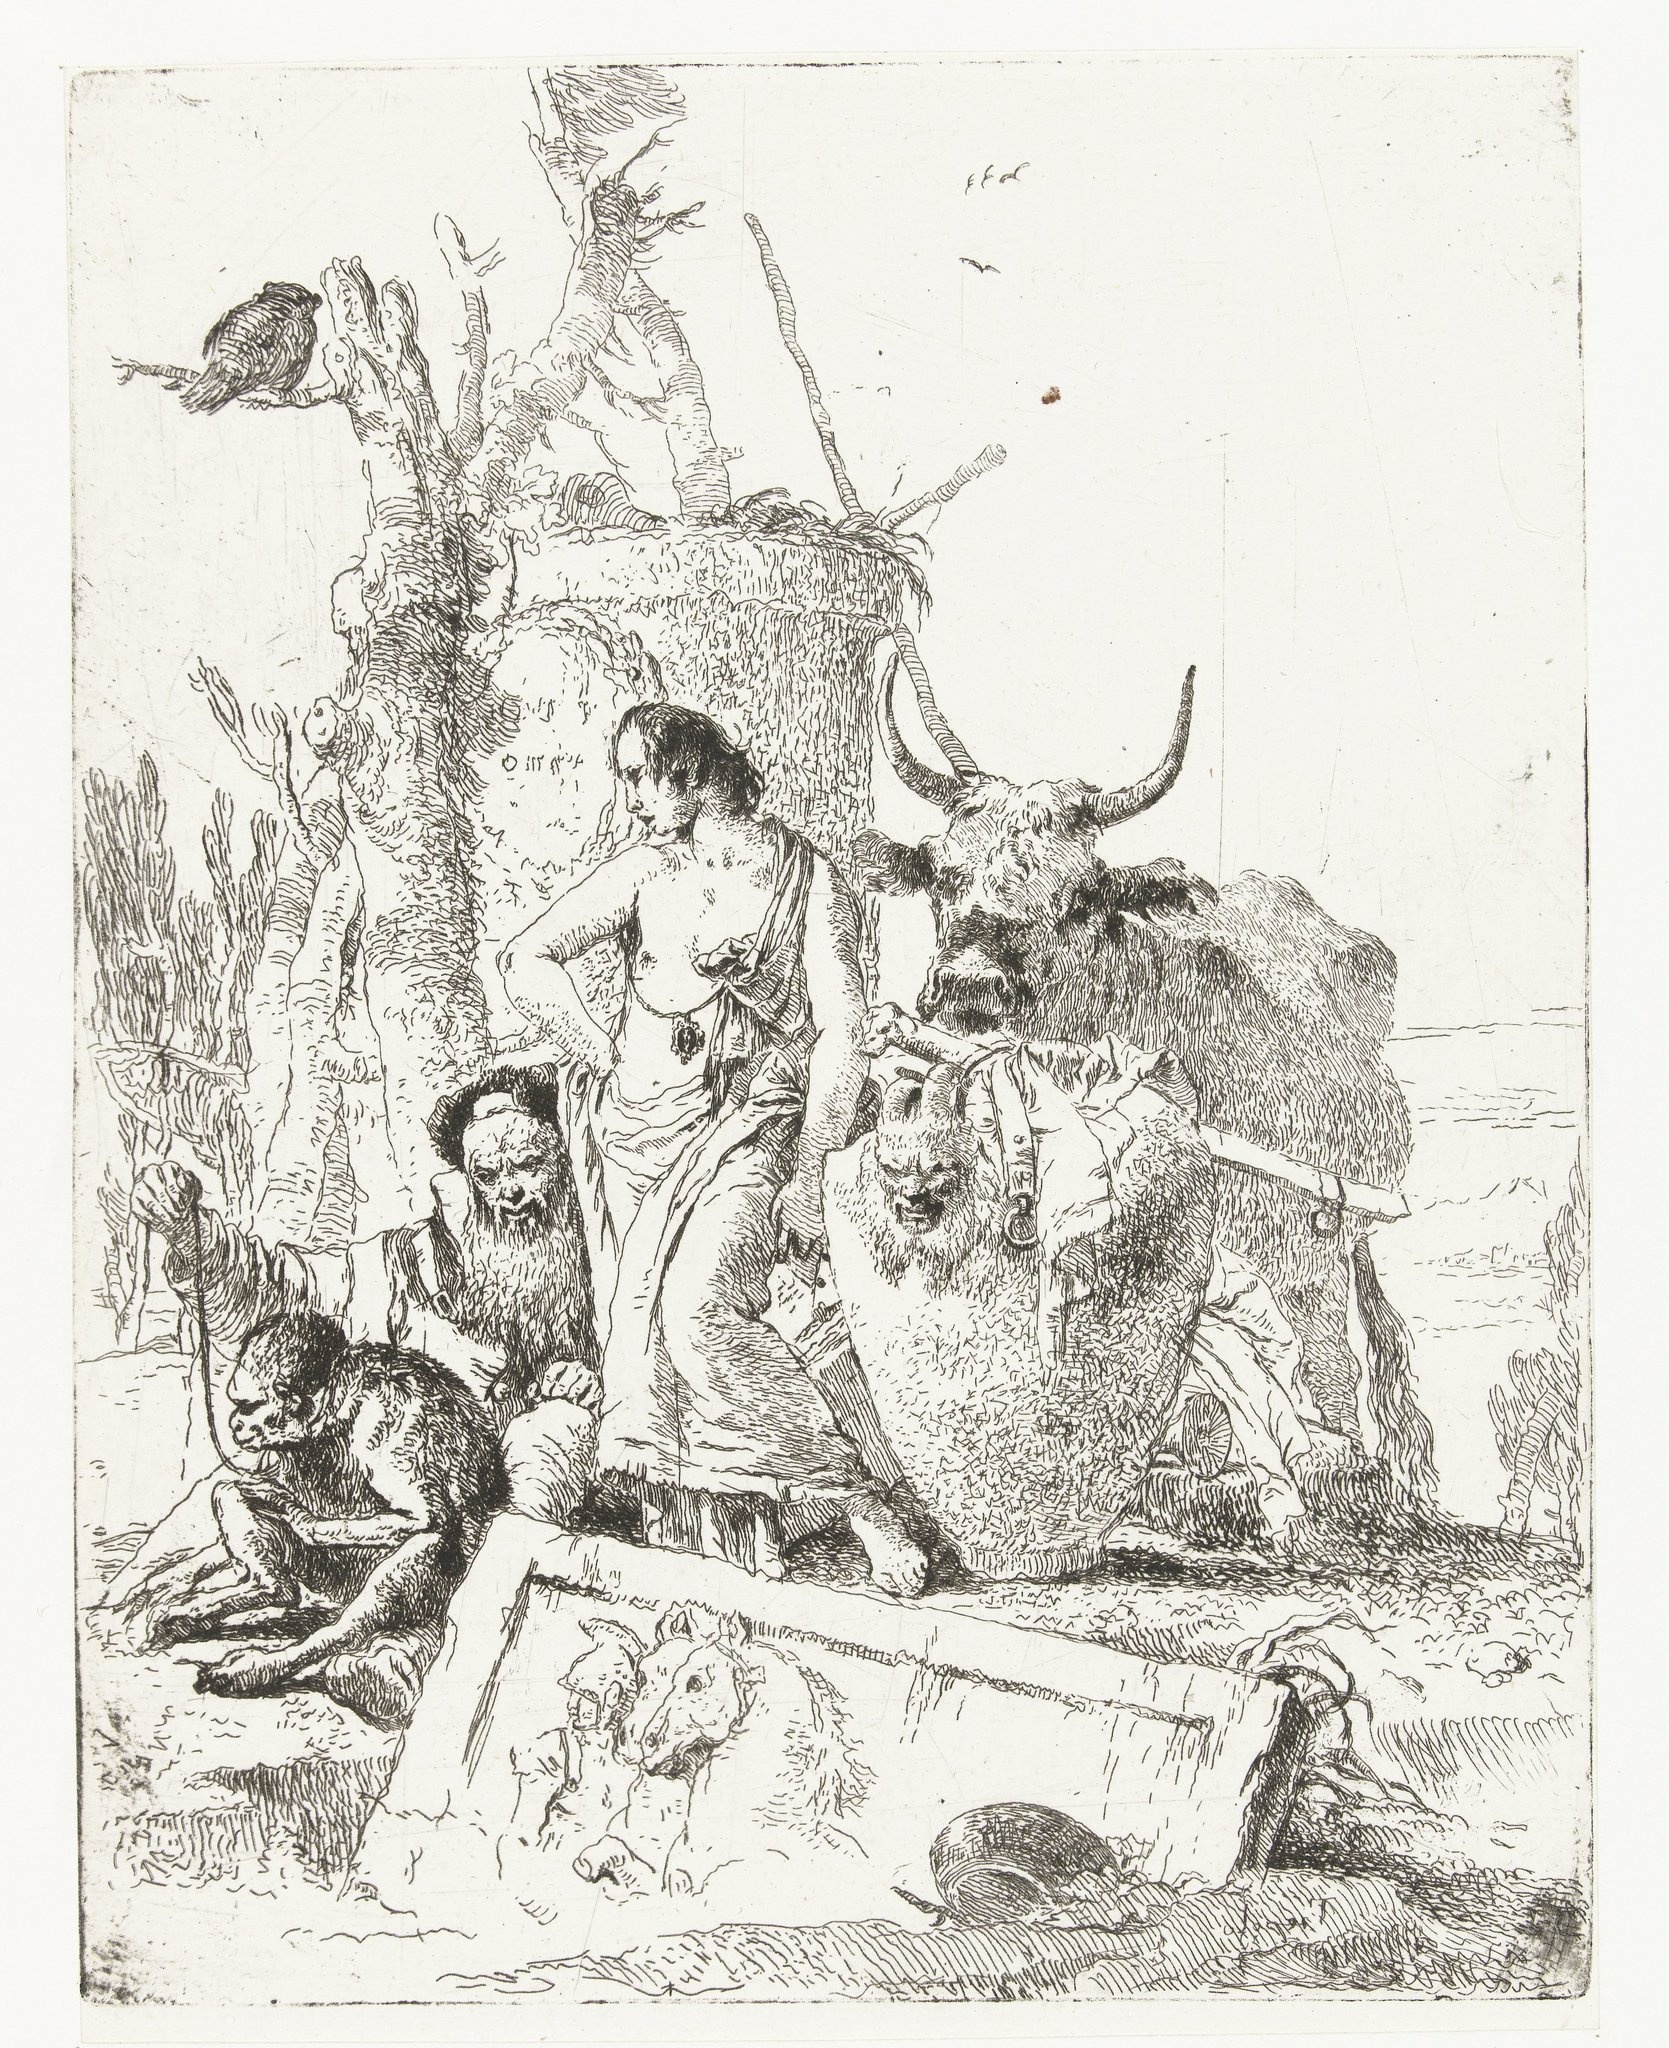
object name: print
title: Zittende tovenaar met aap aan touw en staande figuur naast koe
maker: giovanni battista tiepolo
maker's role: draughtsman, painter, print maker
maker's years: 1696-1770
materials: paper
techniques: etching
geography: italy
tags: monkeys, apes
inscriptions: collector's mark: Lugt 2228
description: Prent maakt deel uit van serie met drieëntwintig prenten, bekend als Scherzi di fantasia. Na Giovanni Battista Tiepolo's dood werden de prenten in wisselende samenstellingen tot twee keer toe uitgegeven door zijn zoon, Giovanni Domenico. De serie in de collectie van het RMA is gedrukt in de eerste staat voor deze uitgaven, herkenbaar aan het ontbreken van een nummering.